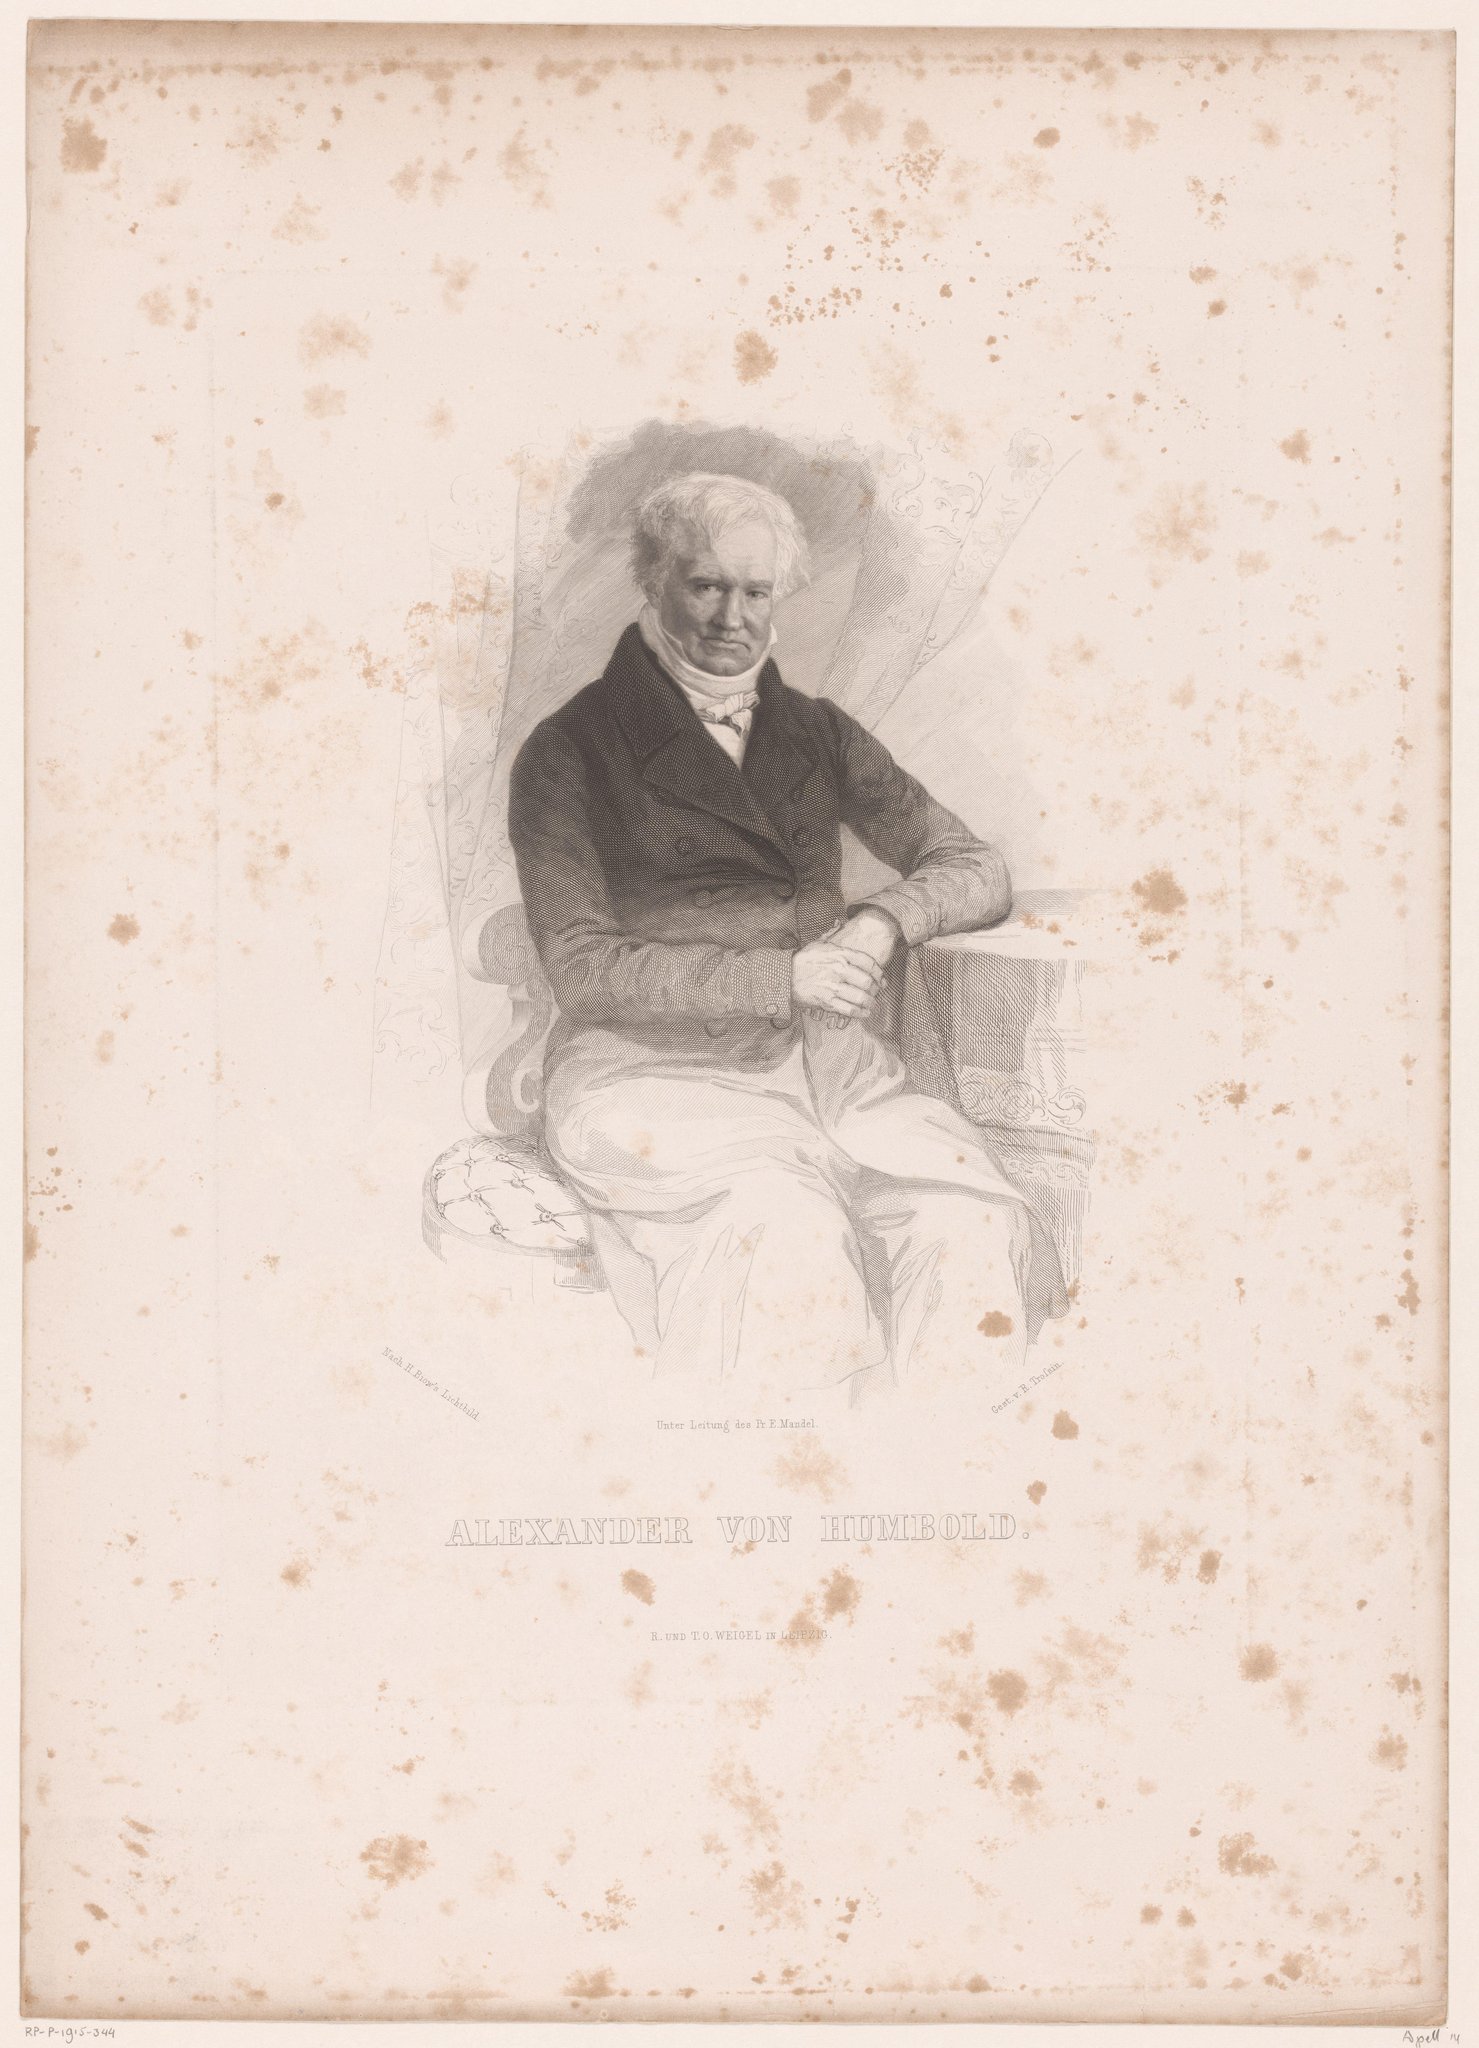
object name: print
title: Portret van Alexander von Humboldt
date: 1830-1882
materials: paper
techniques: engraving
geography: germany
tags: berlin, traveler, historical persons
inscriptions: collector's mark: Lugt 2228